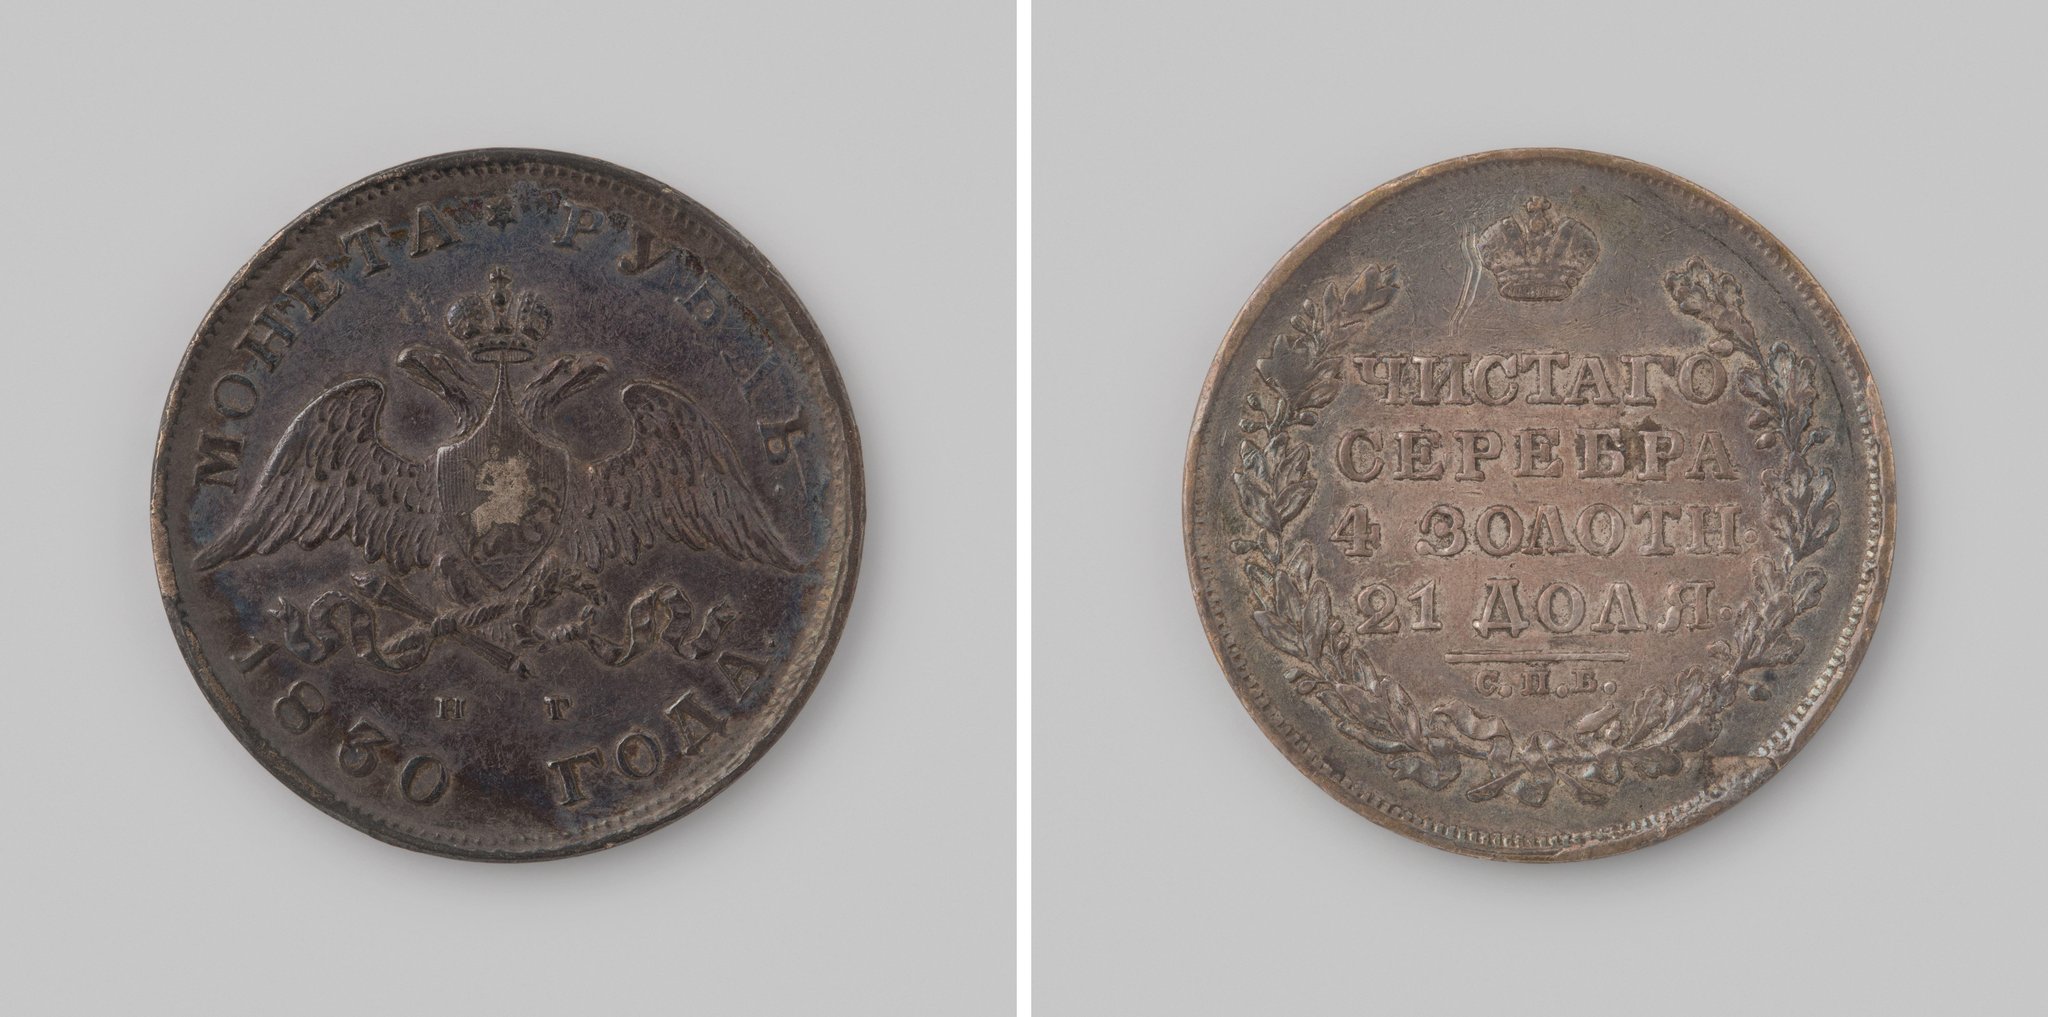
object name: coin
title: Roebel uit Rusland van tsaar Nikolai I, 1830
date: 1830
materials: silver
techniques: striking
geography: sint-petersburg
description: Zilveren munt. Voorzijde: dubbelkoppige adelaar met gespreide vleugels, met op zijn borst een wapenschild en op zijn staart versierselen. Boven de adelaar een kroon. Waarde-aanduiding en jaartal in het omschrift. Keerzijde: binnen twee samengebonden takken onder een kroon opschrift in vier regels. Daaronder de letters S, P en B in Cyrillisch schrift. Randschrift.